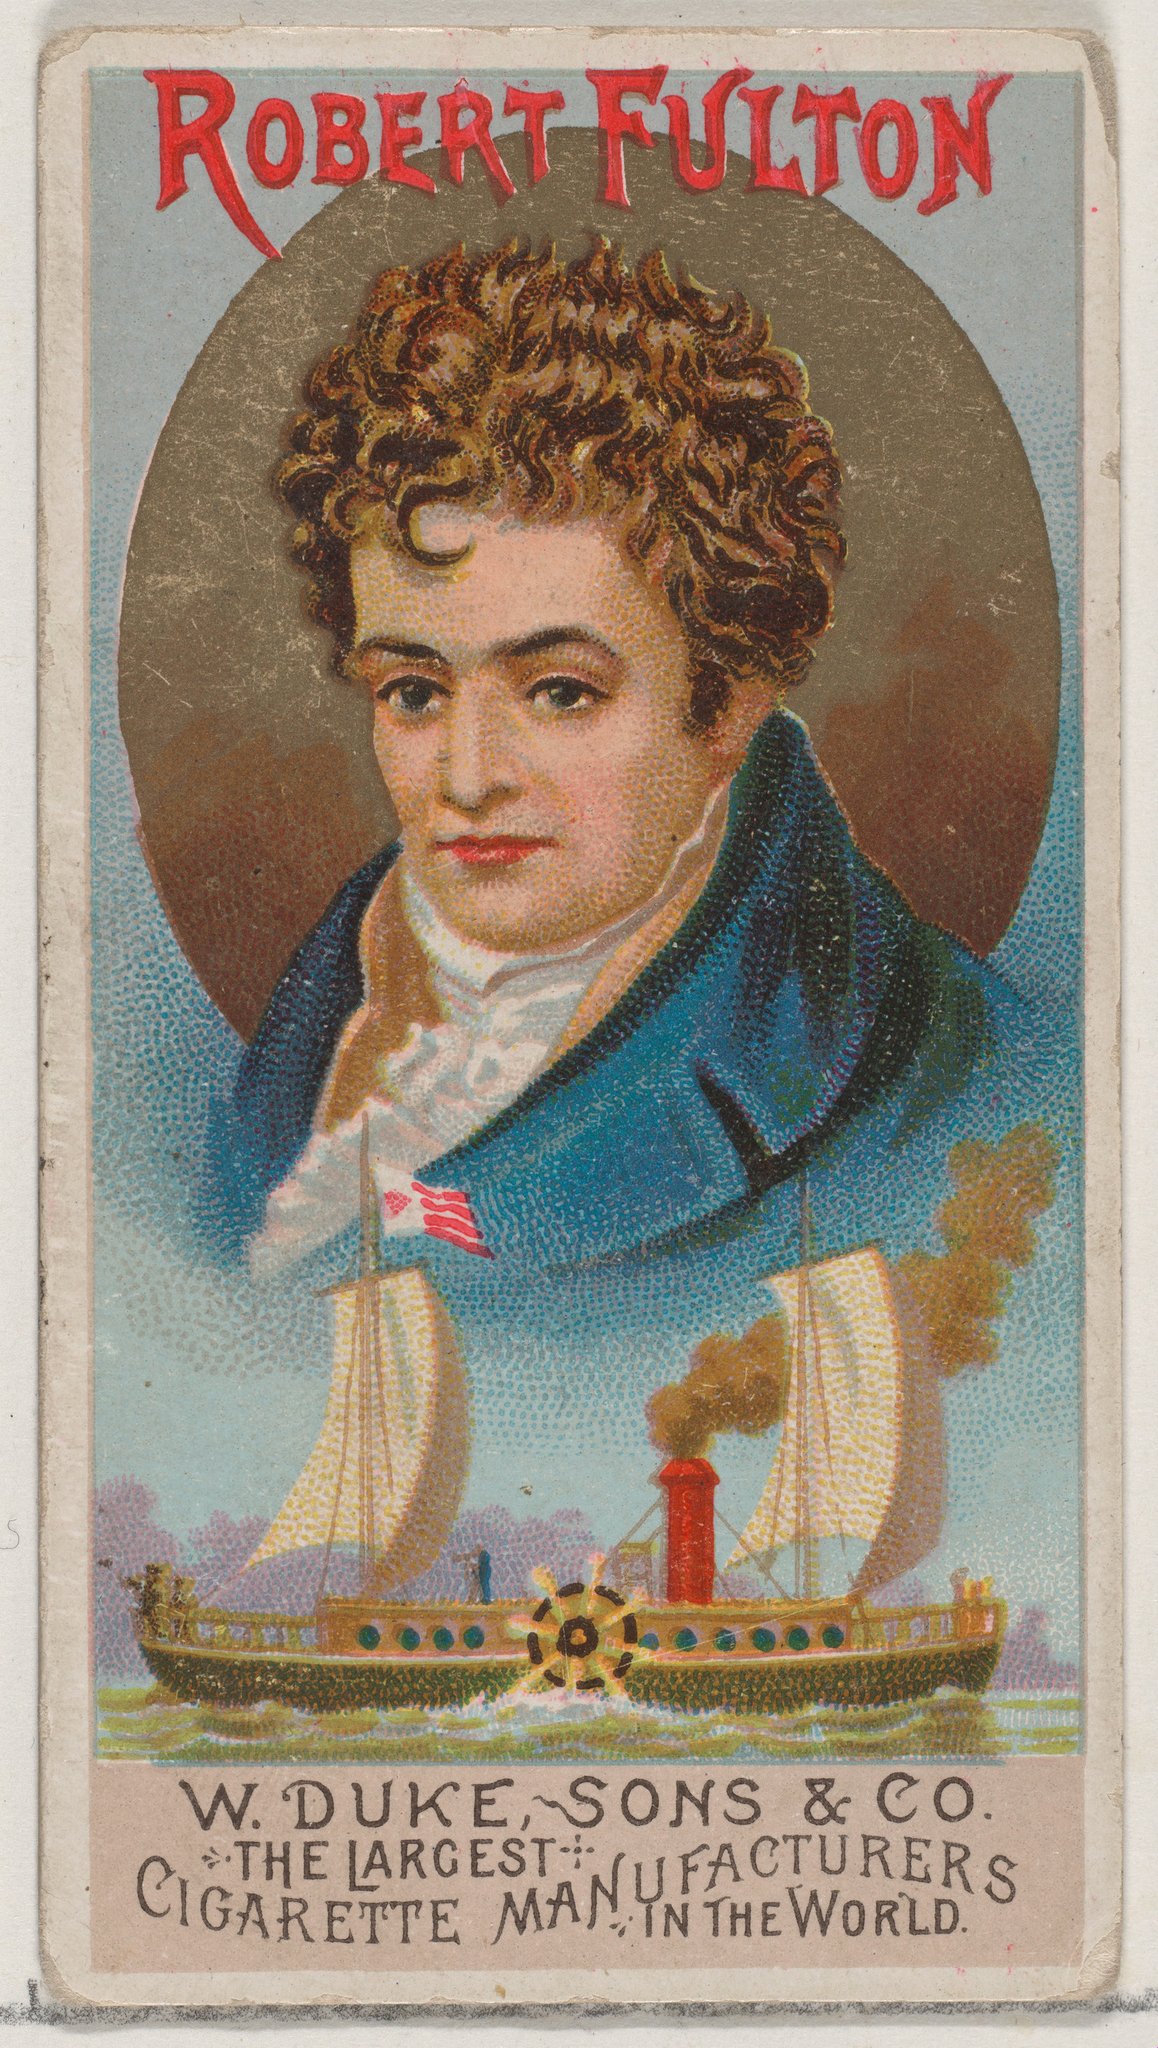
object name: print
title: Robert Fulton, from the series Great Americans (N76) for Duke brand cigarettes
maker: w. duke, sons & co.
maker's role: publisher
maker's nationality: american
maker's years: 1870-1920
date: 1888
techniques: color lithograph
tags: men